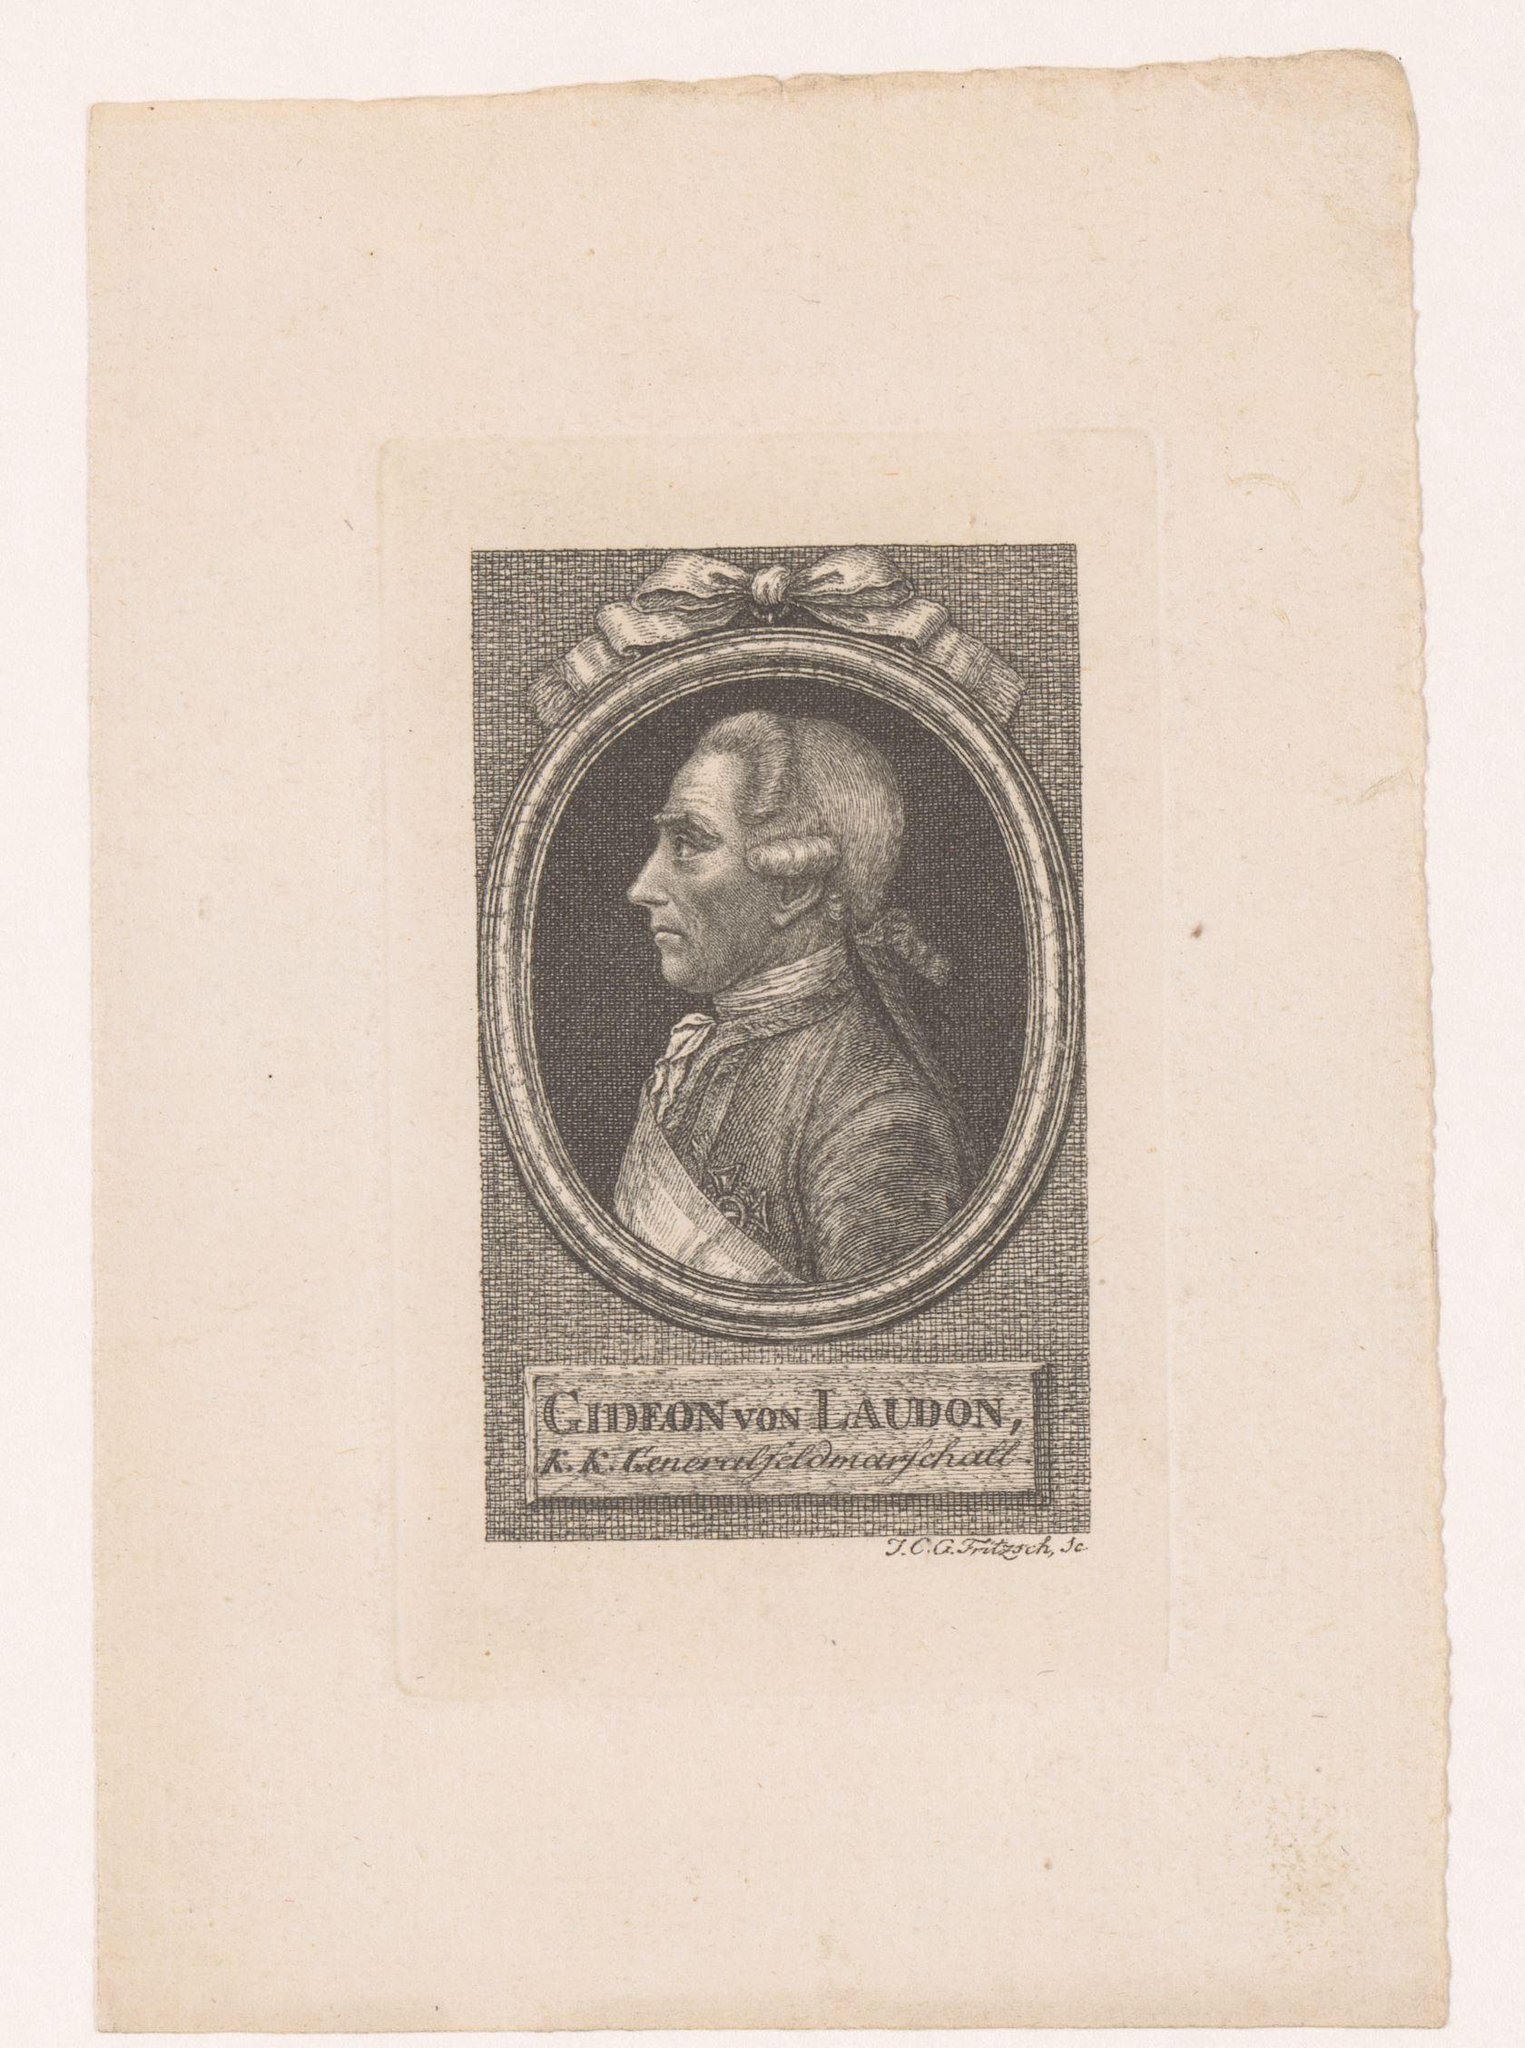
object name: print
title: Portret van Gideon Ernst von Laudon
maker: johann christian gottfried fritzsch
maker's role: print maker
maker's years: 1720-1802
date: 1730-1790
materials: paper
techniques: engraving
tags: knighthood order, ornament ~ medallion, historical persons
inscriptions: collector's mark: Lugt 2228